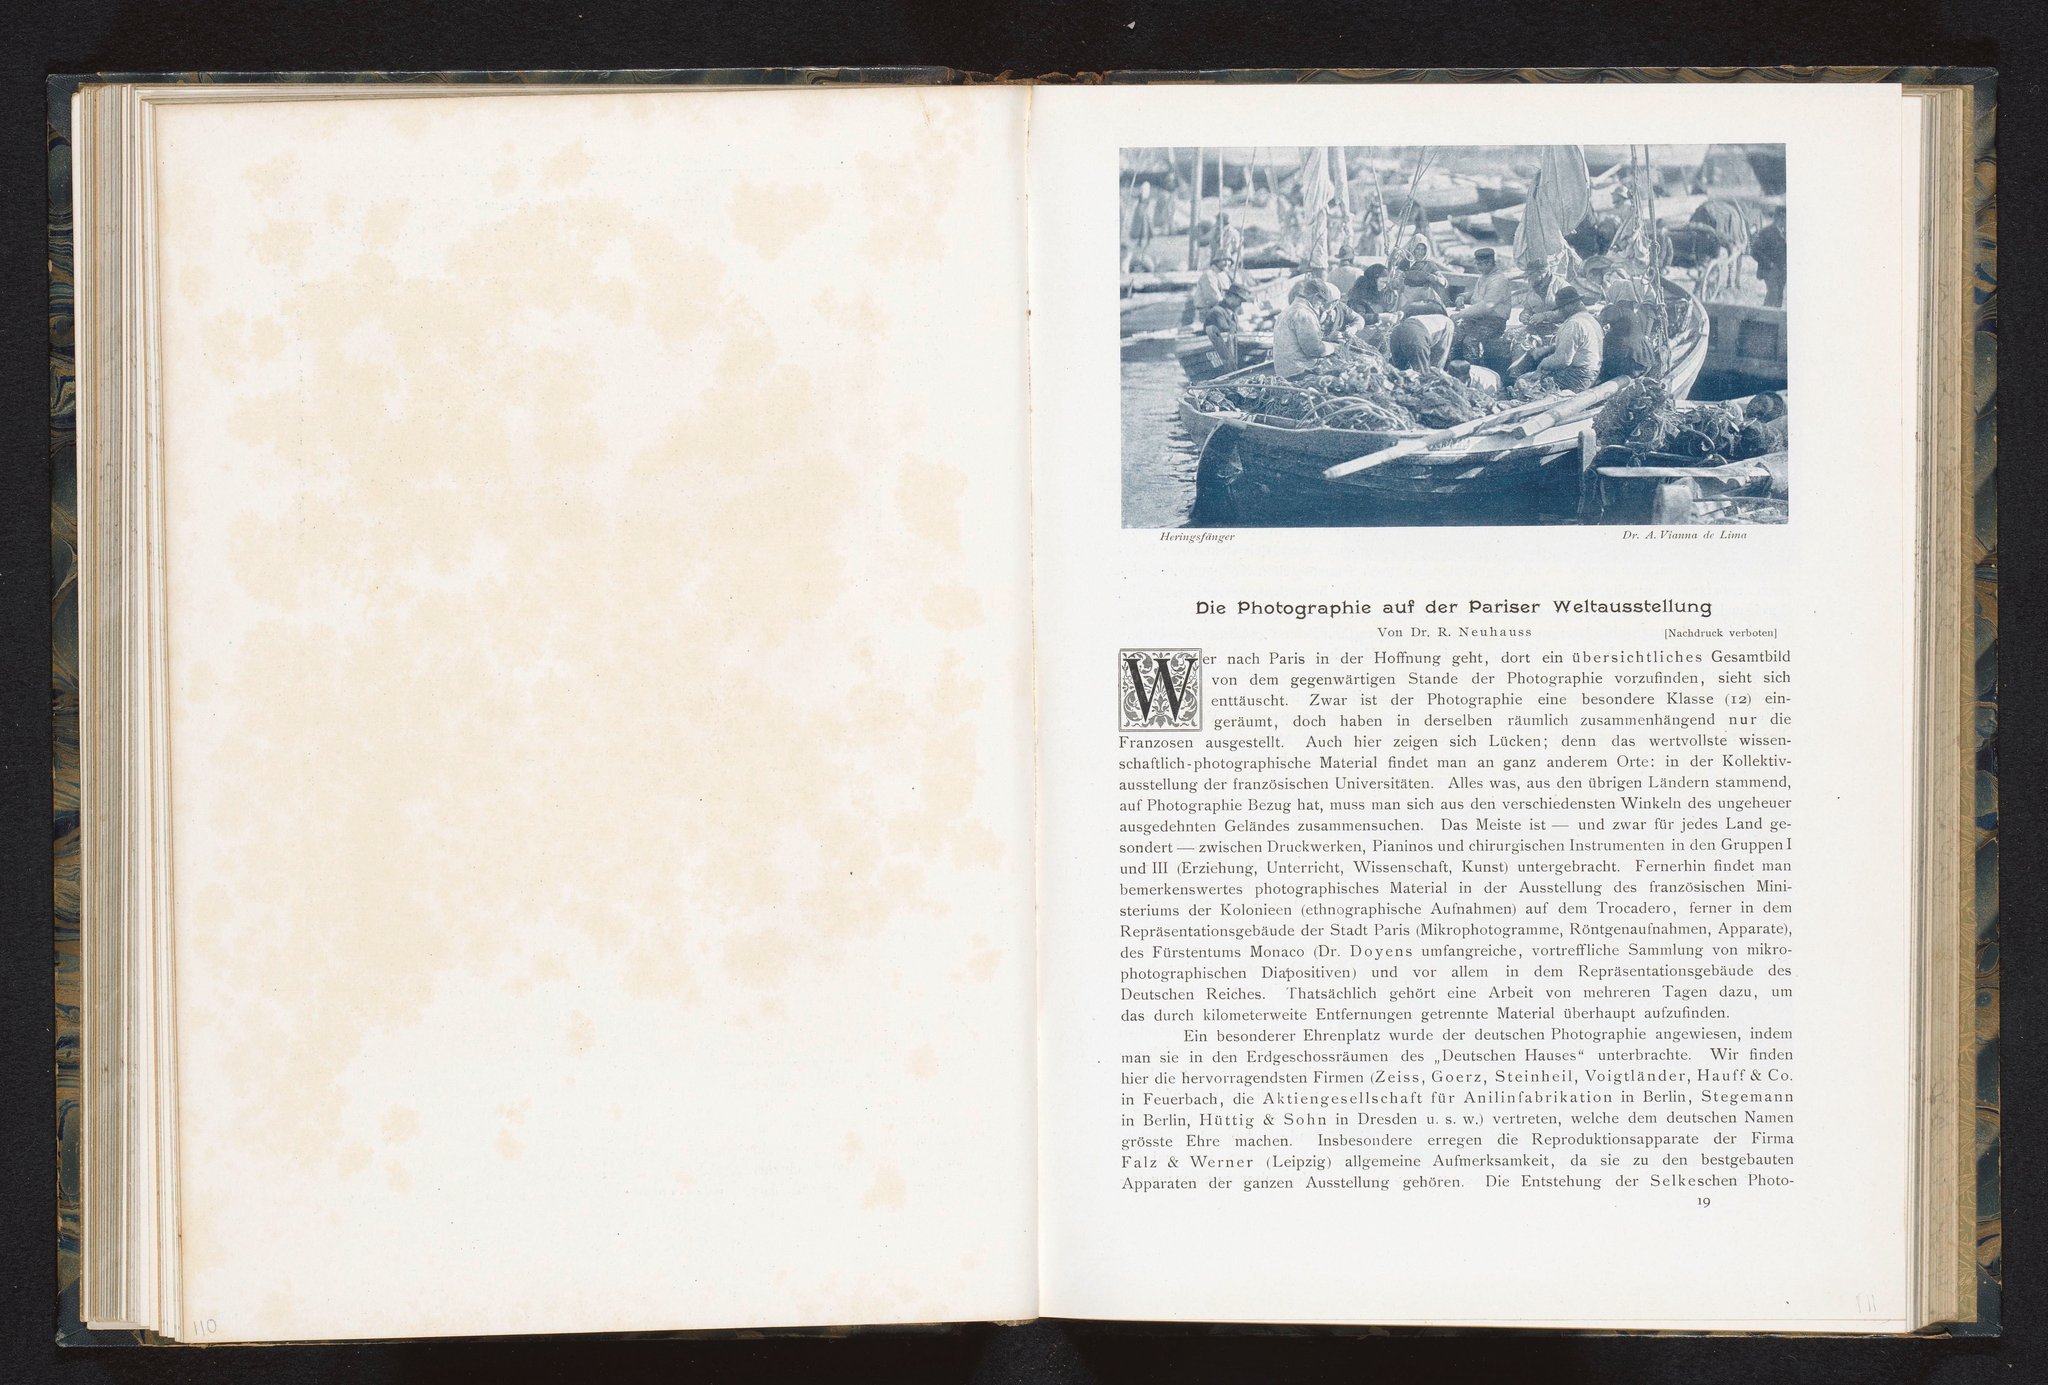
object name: photomechanical print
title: Gezicht op vissersboten in een haven met opvarenden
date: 1895-1900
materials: paper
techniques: autotype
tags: rowing-boat, canoe, etc., fisherman